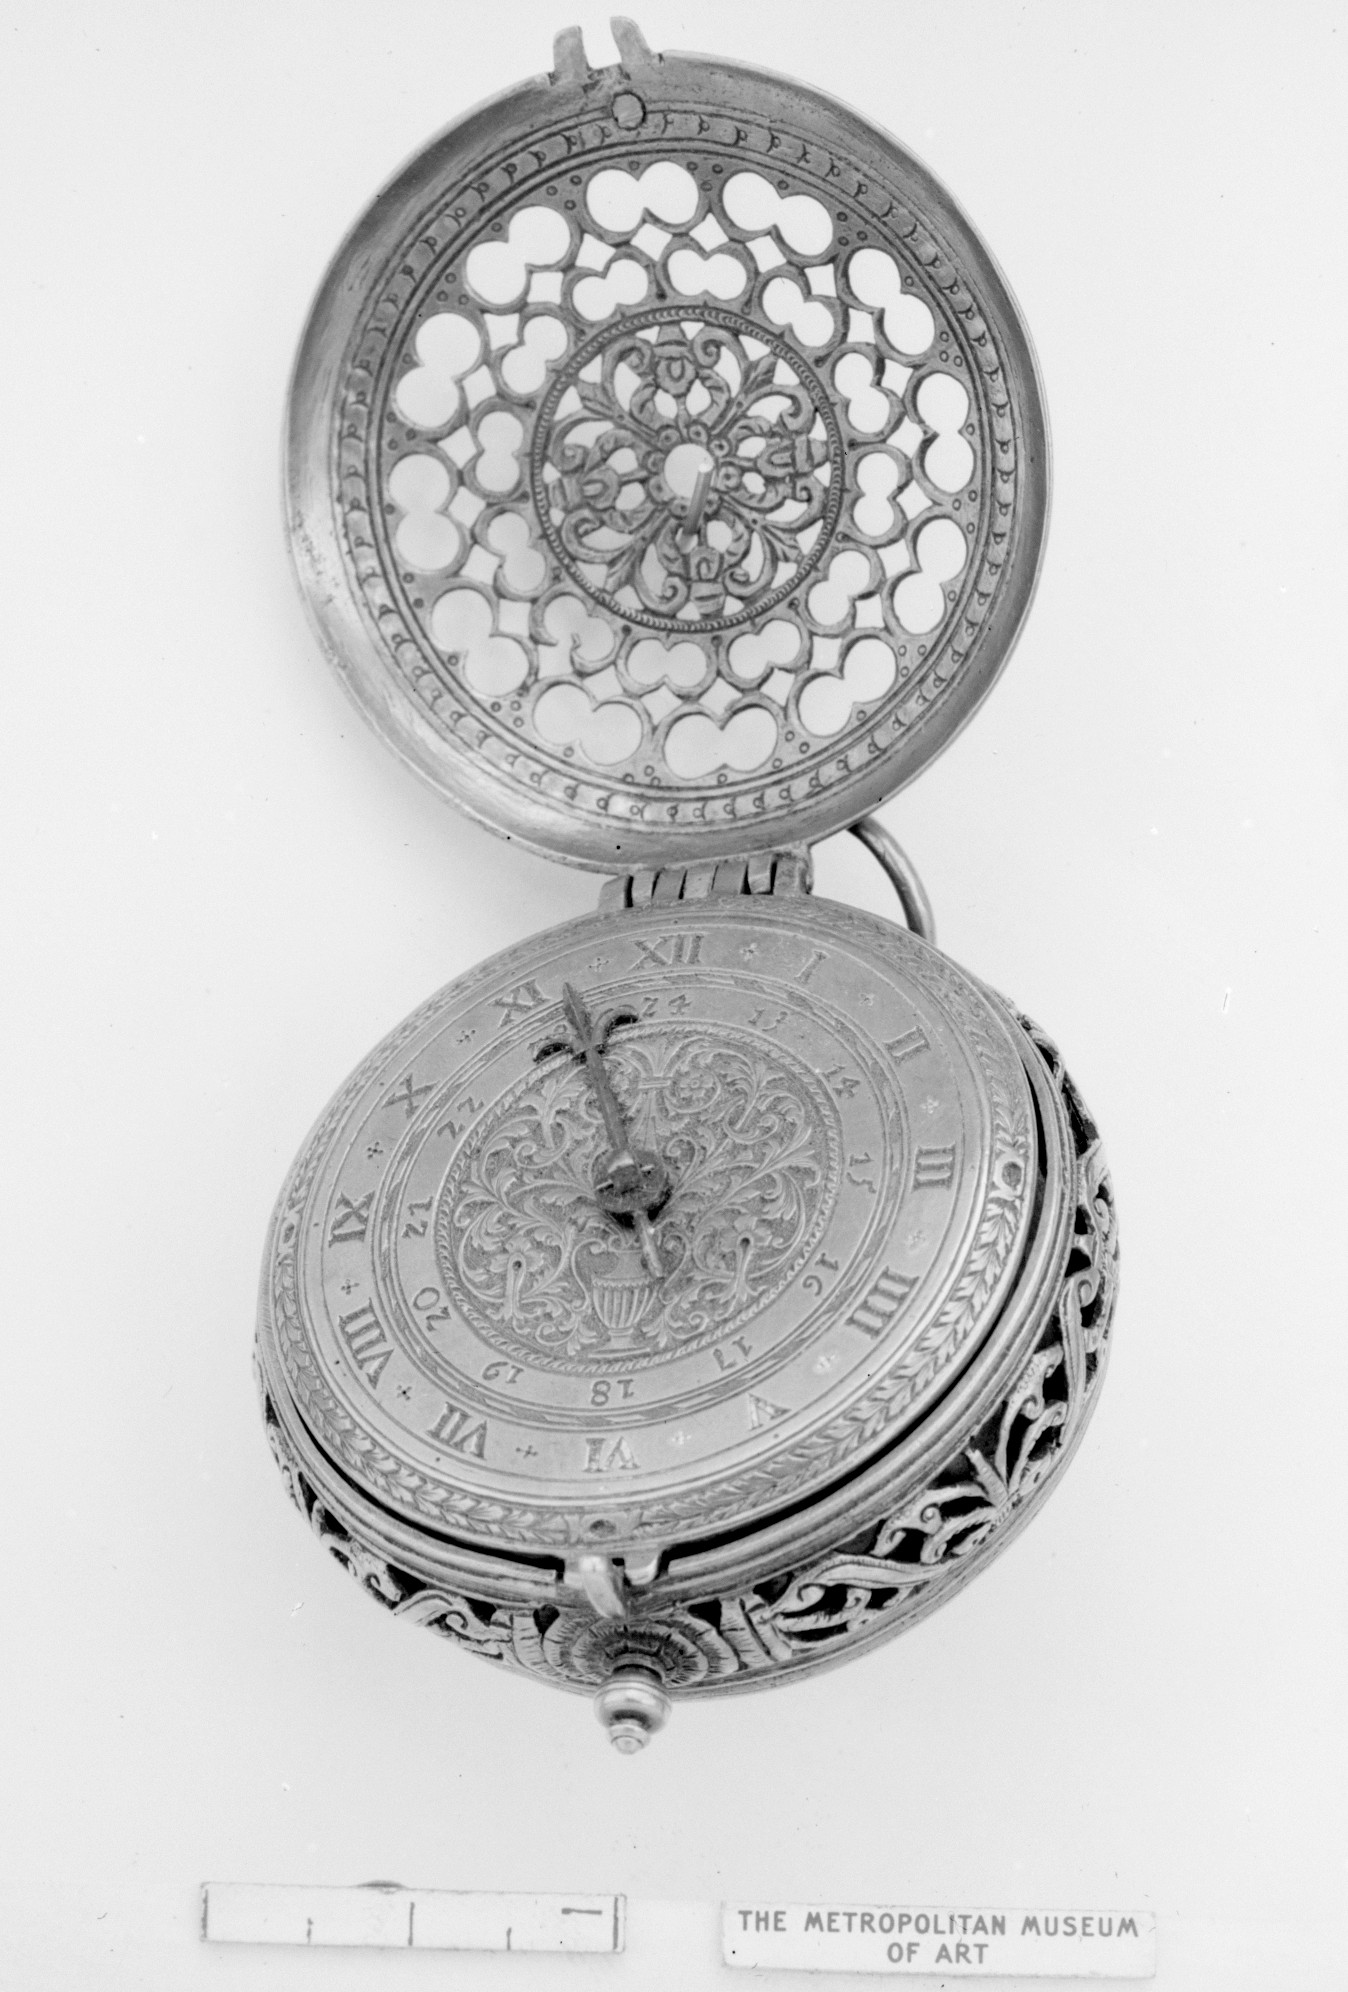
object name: clock watch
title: Clock-watch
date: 1570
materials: bronze, iron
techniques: gilding